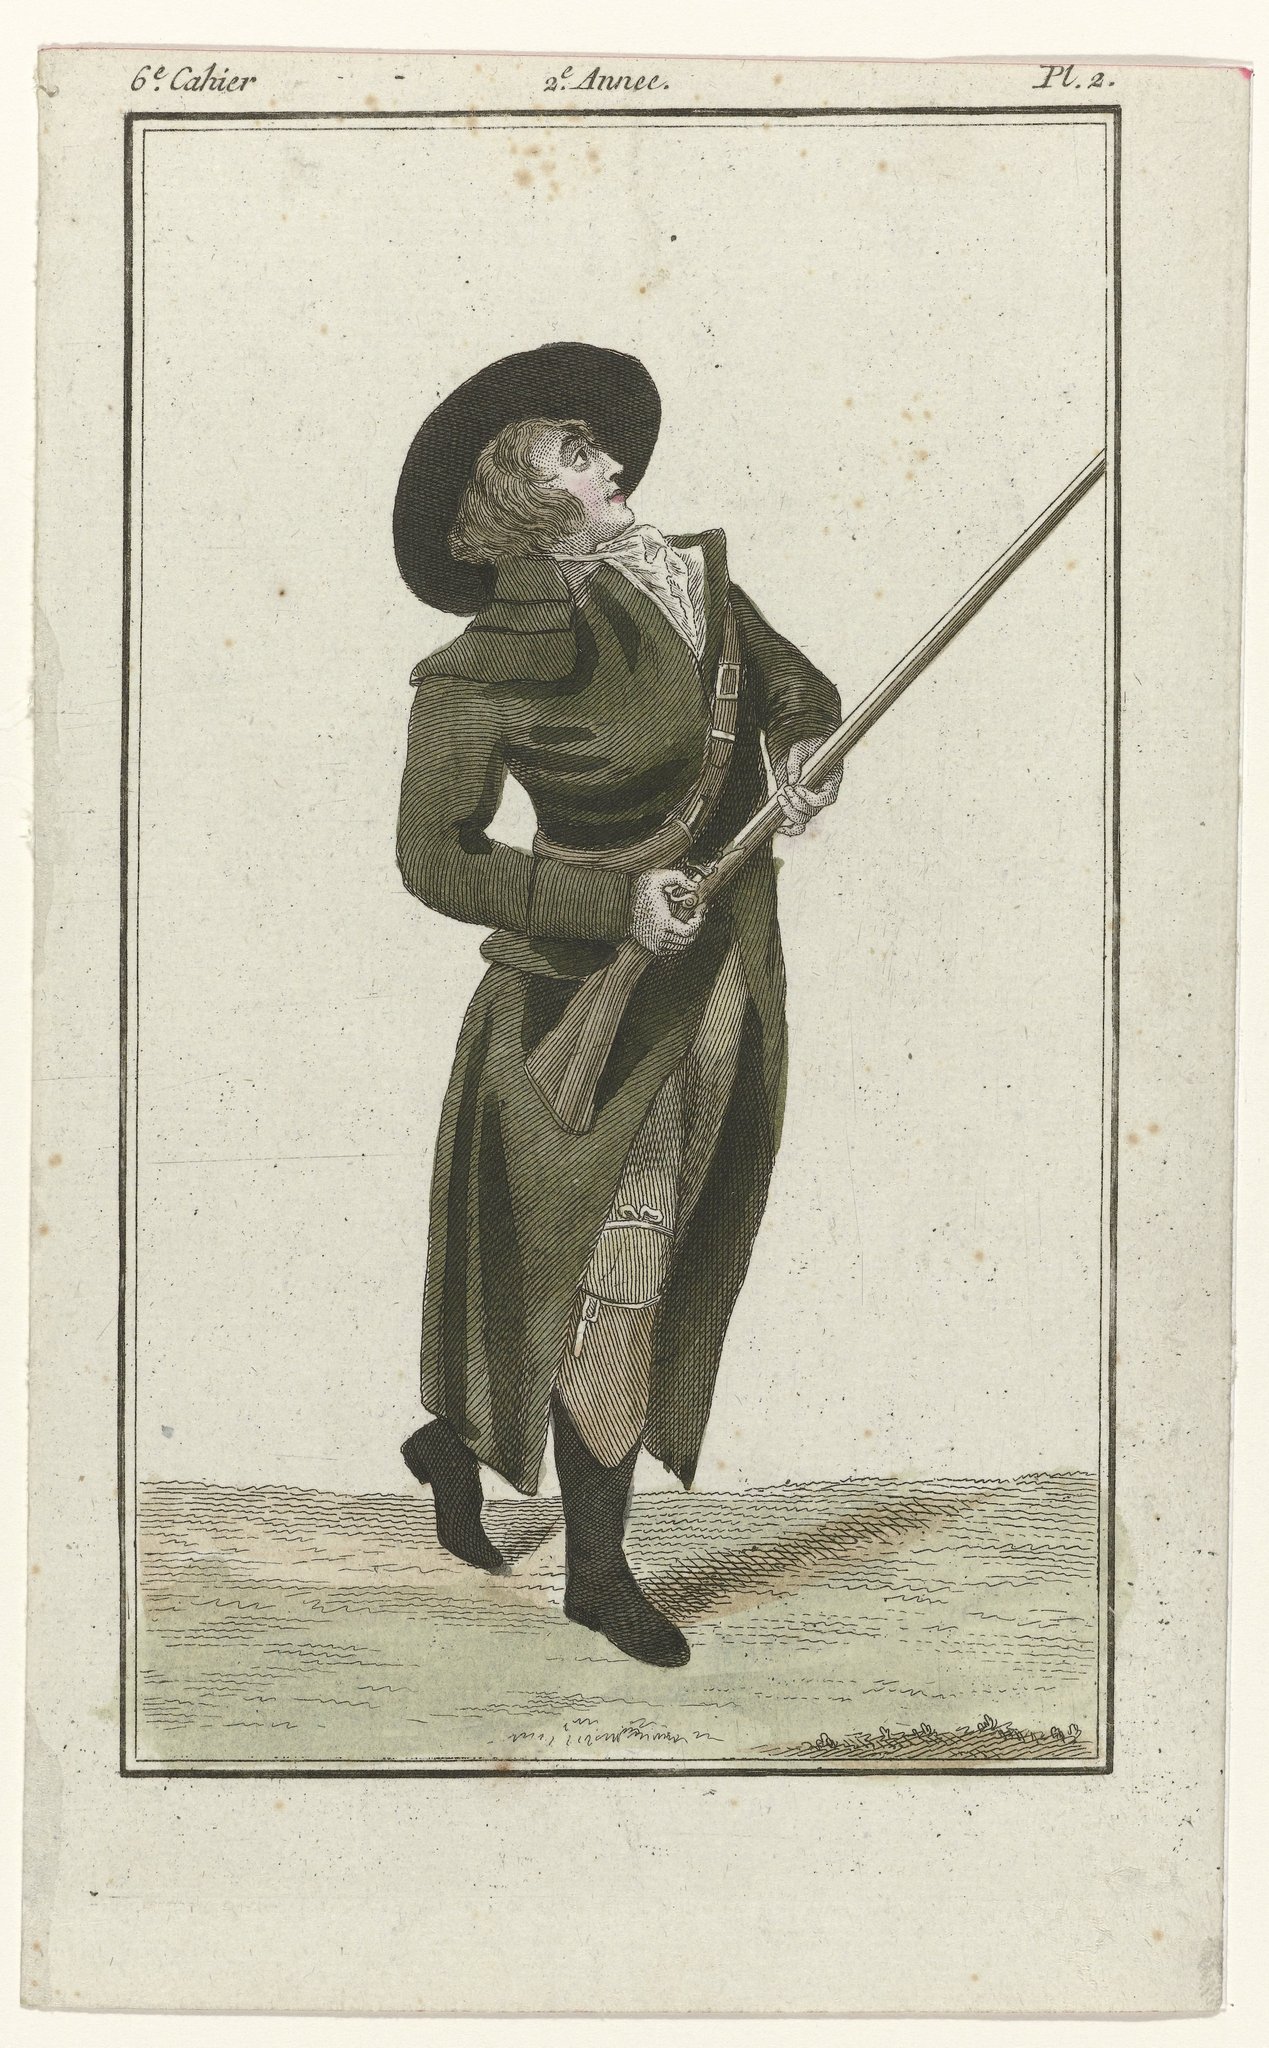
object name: fashion print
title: Magasin des Modes Nouvelles Françaises et Anglaises, kopie naar 10 janvier 1787, Pl. 2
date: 1787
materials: paper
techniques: engraving, hand coloring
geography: liège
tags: hunter (+ hunting weapons, equipment, outfit), shoulder-belt, bandoleer (+ men's clothes), ensembles of pieces of clothing (hunting costume) (+ men's clothes), coat (+ men's clothes), head-gear: hat (+ men's clothes), fashion plates, clothing for the upper part of the body (+ men's clothes), firearms, trousers, breeches, etc. (breeches) (+ men's clothes)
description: Lopende Engelsman naar rechts, met een geweer in de handen. Hij draagt een jachtkostuum, bestaande uit een grote redingote van laken met drie schouderkragen,hemd (?), kniebroek en kousen. Accessoires: hoed met brede rand, bandelier en laarzen. De prent is een kopie door uitgever J.J. Tuttot in Luik naar Pl. 2, 2e Année, 6e Cahier, uit de serie Magasin des Modes Nouvelles Françaises et Anglaises. Deze serie bestaat uit 172 modeprenten, uitgegeven door Buisson, Parijs, 20 novembre 1786 - 21 décembre 1789.